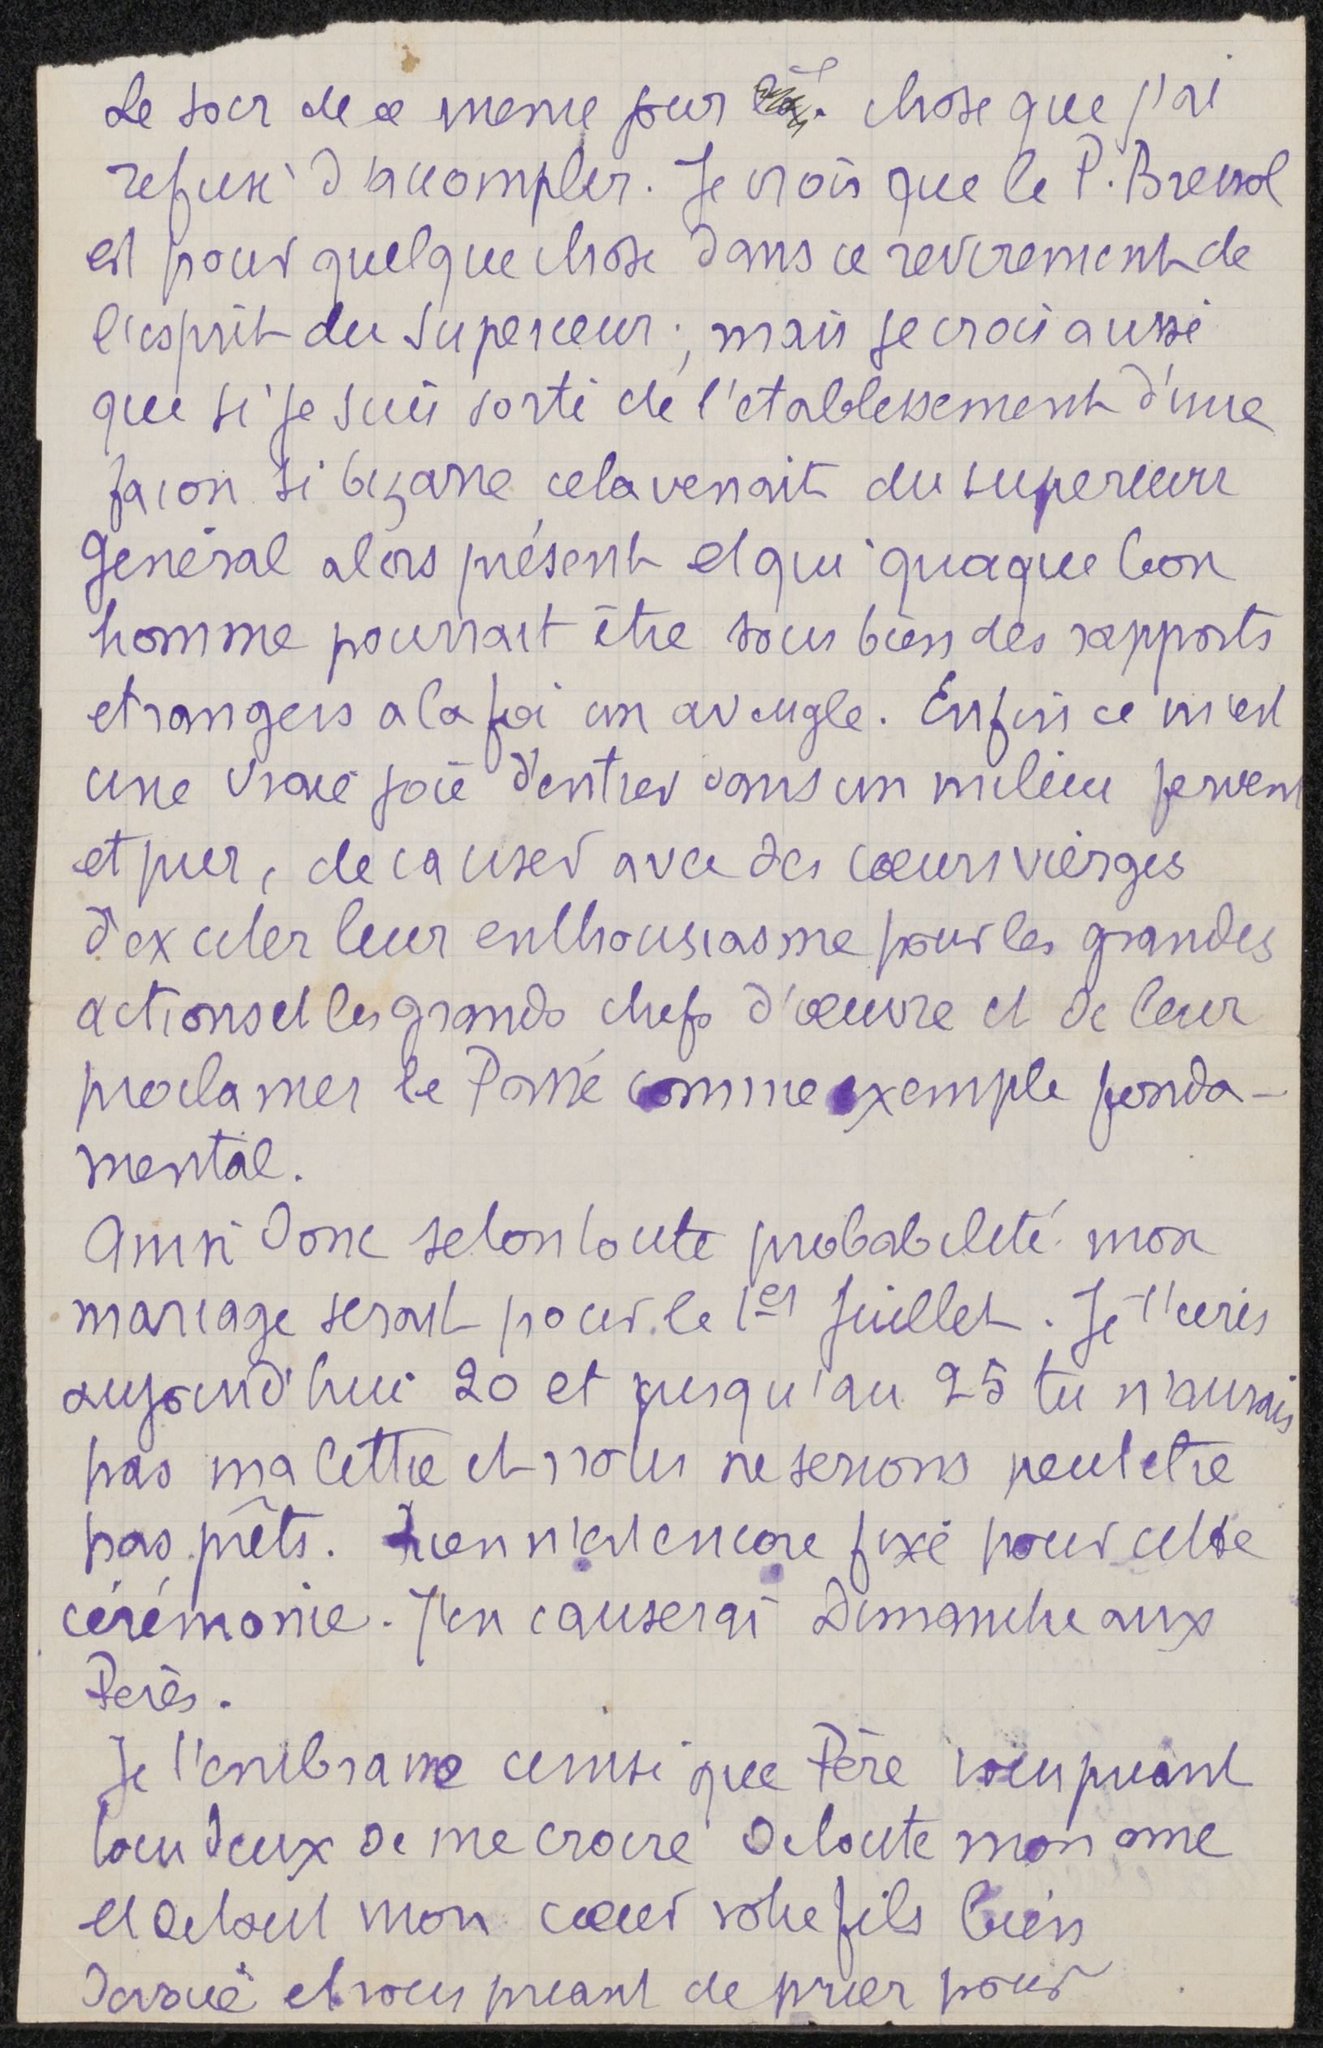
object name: letter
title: Brief aan Héloïse Bernard-Bodin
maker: émile bernard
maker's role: print maker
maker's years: 1868-1941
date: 1894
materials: ink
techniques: pen, writing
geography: cairo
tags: painter, paris, charles baudelaire, drawing, photography, cinematography, family life, painting (including book-illumination, miniature-painting), workshop, studio of the artist (in general)